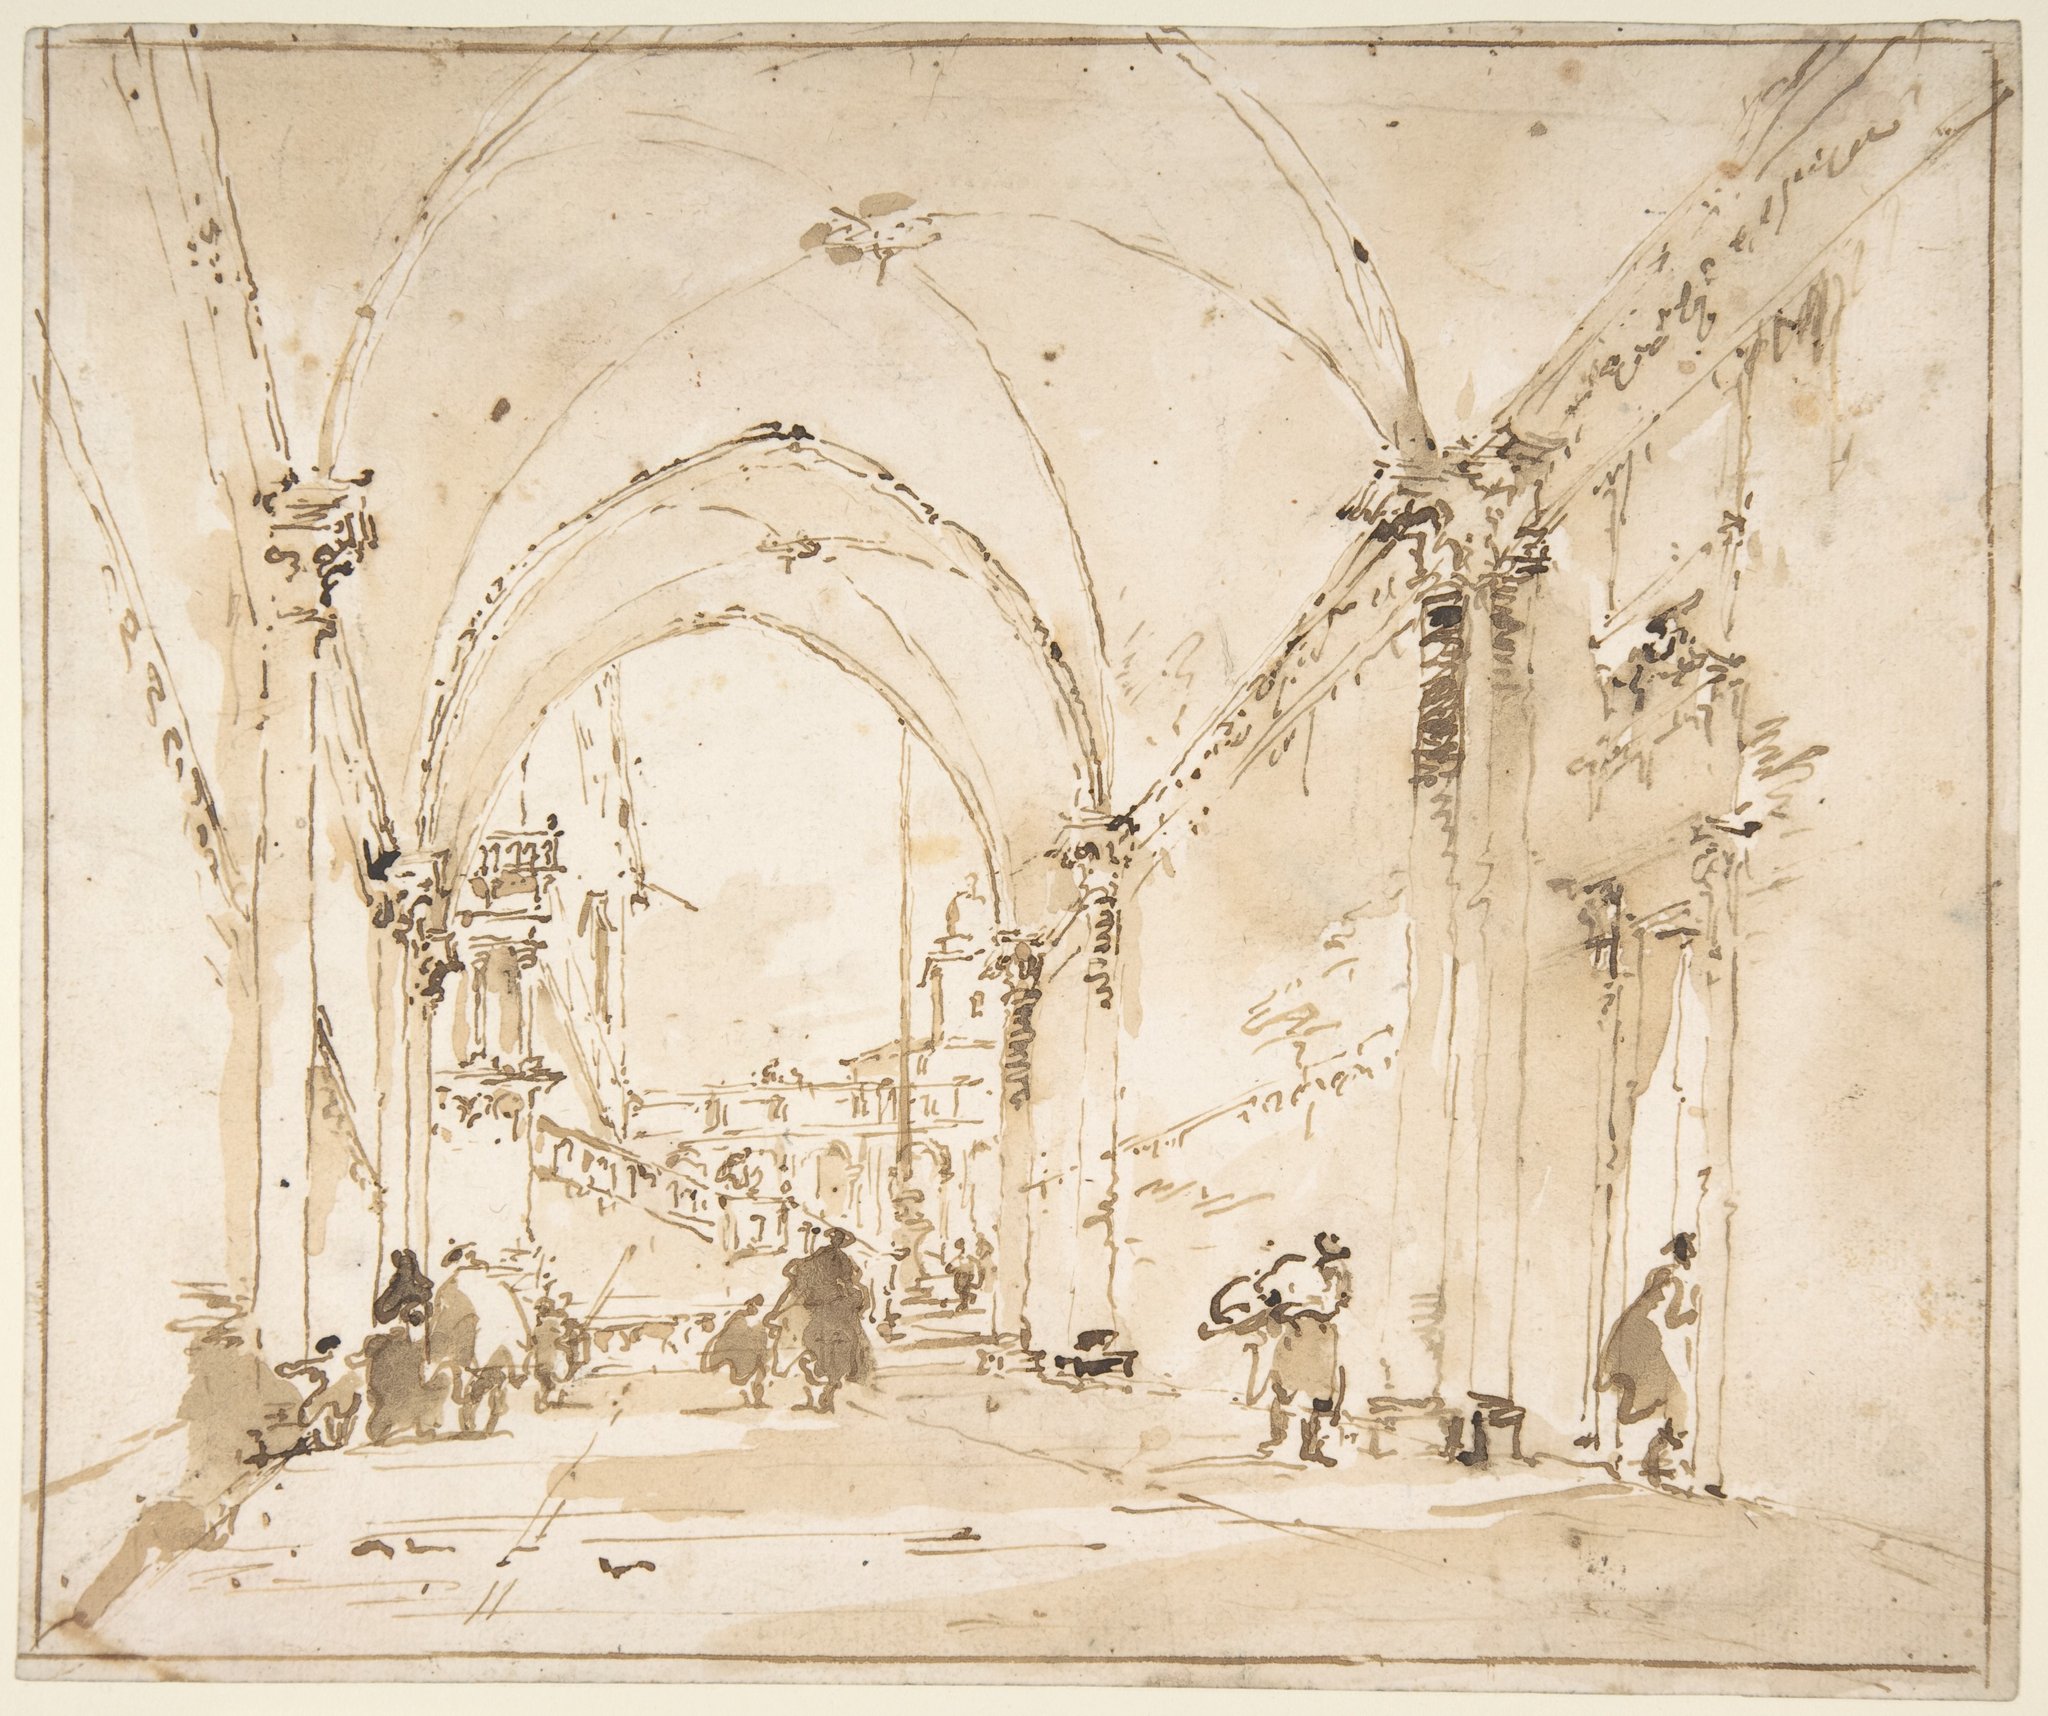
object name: drawing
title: Architectural Capriccio: Vaulted Passageway Leading to a Square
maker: francesco guardi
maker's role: artist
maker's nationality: italian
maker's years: 1712-1793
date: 1712-1793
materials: chalk, ink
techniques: brush, pen, wash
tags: arches,buildings